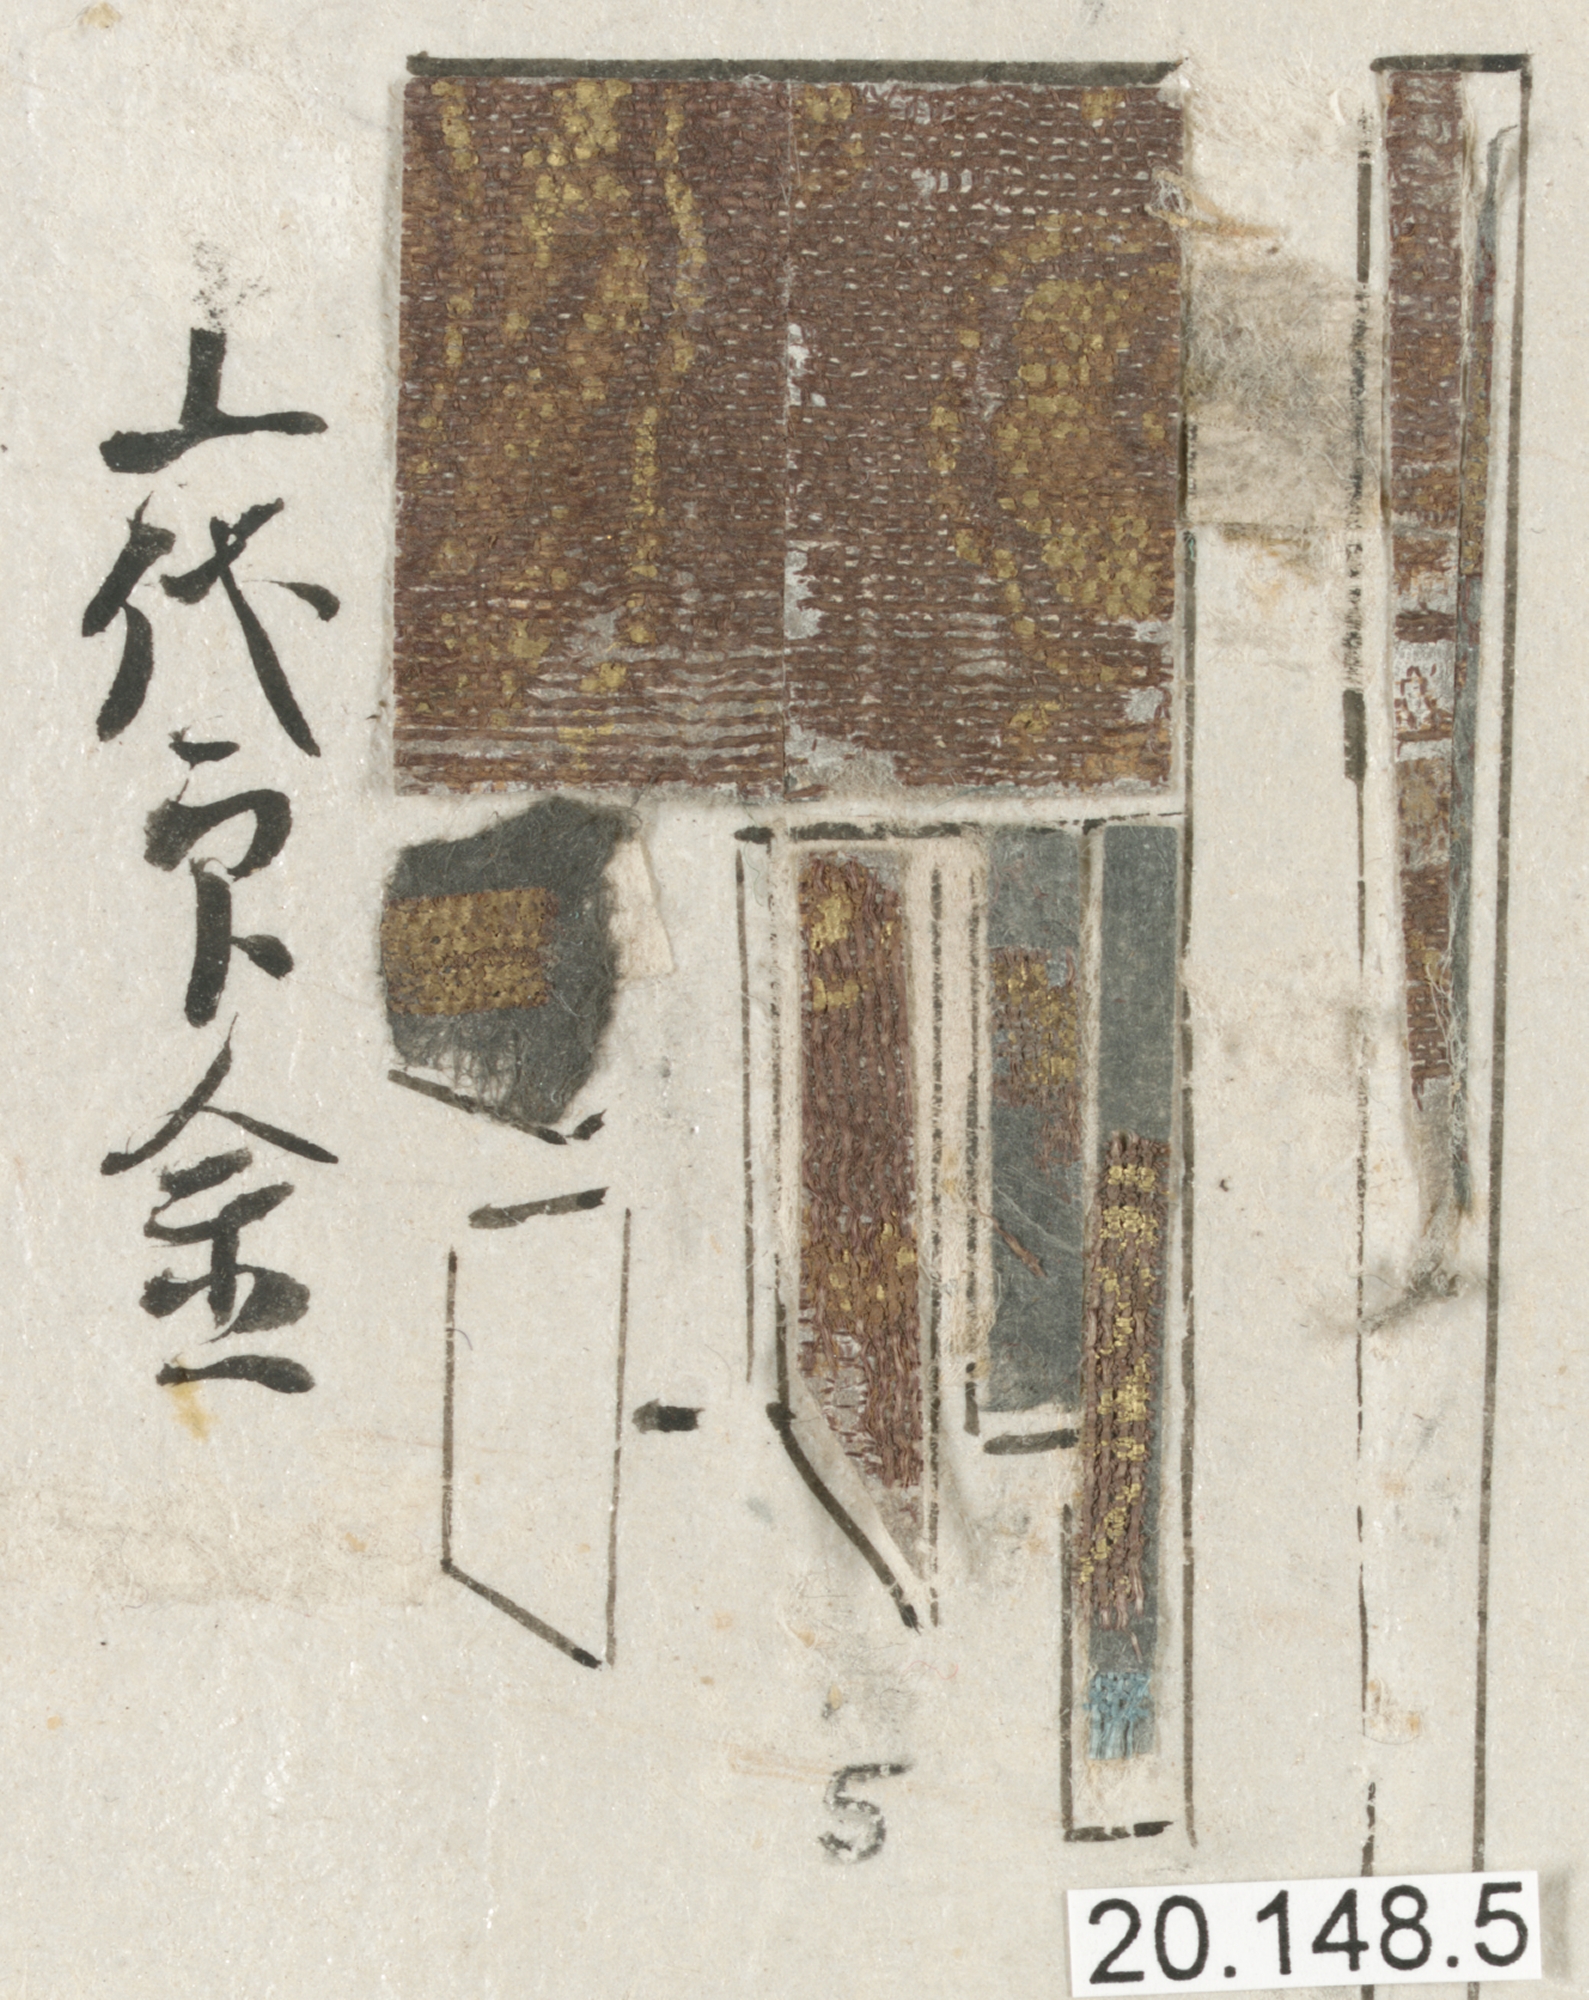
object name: piece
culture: japanese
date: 901-1000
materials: silk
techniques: compound weave